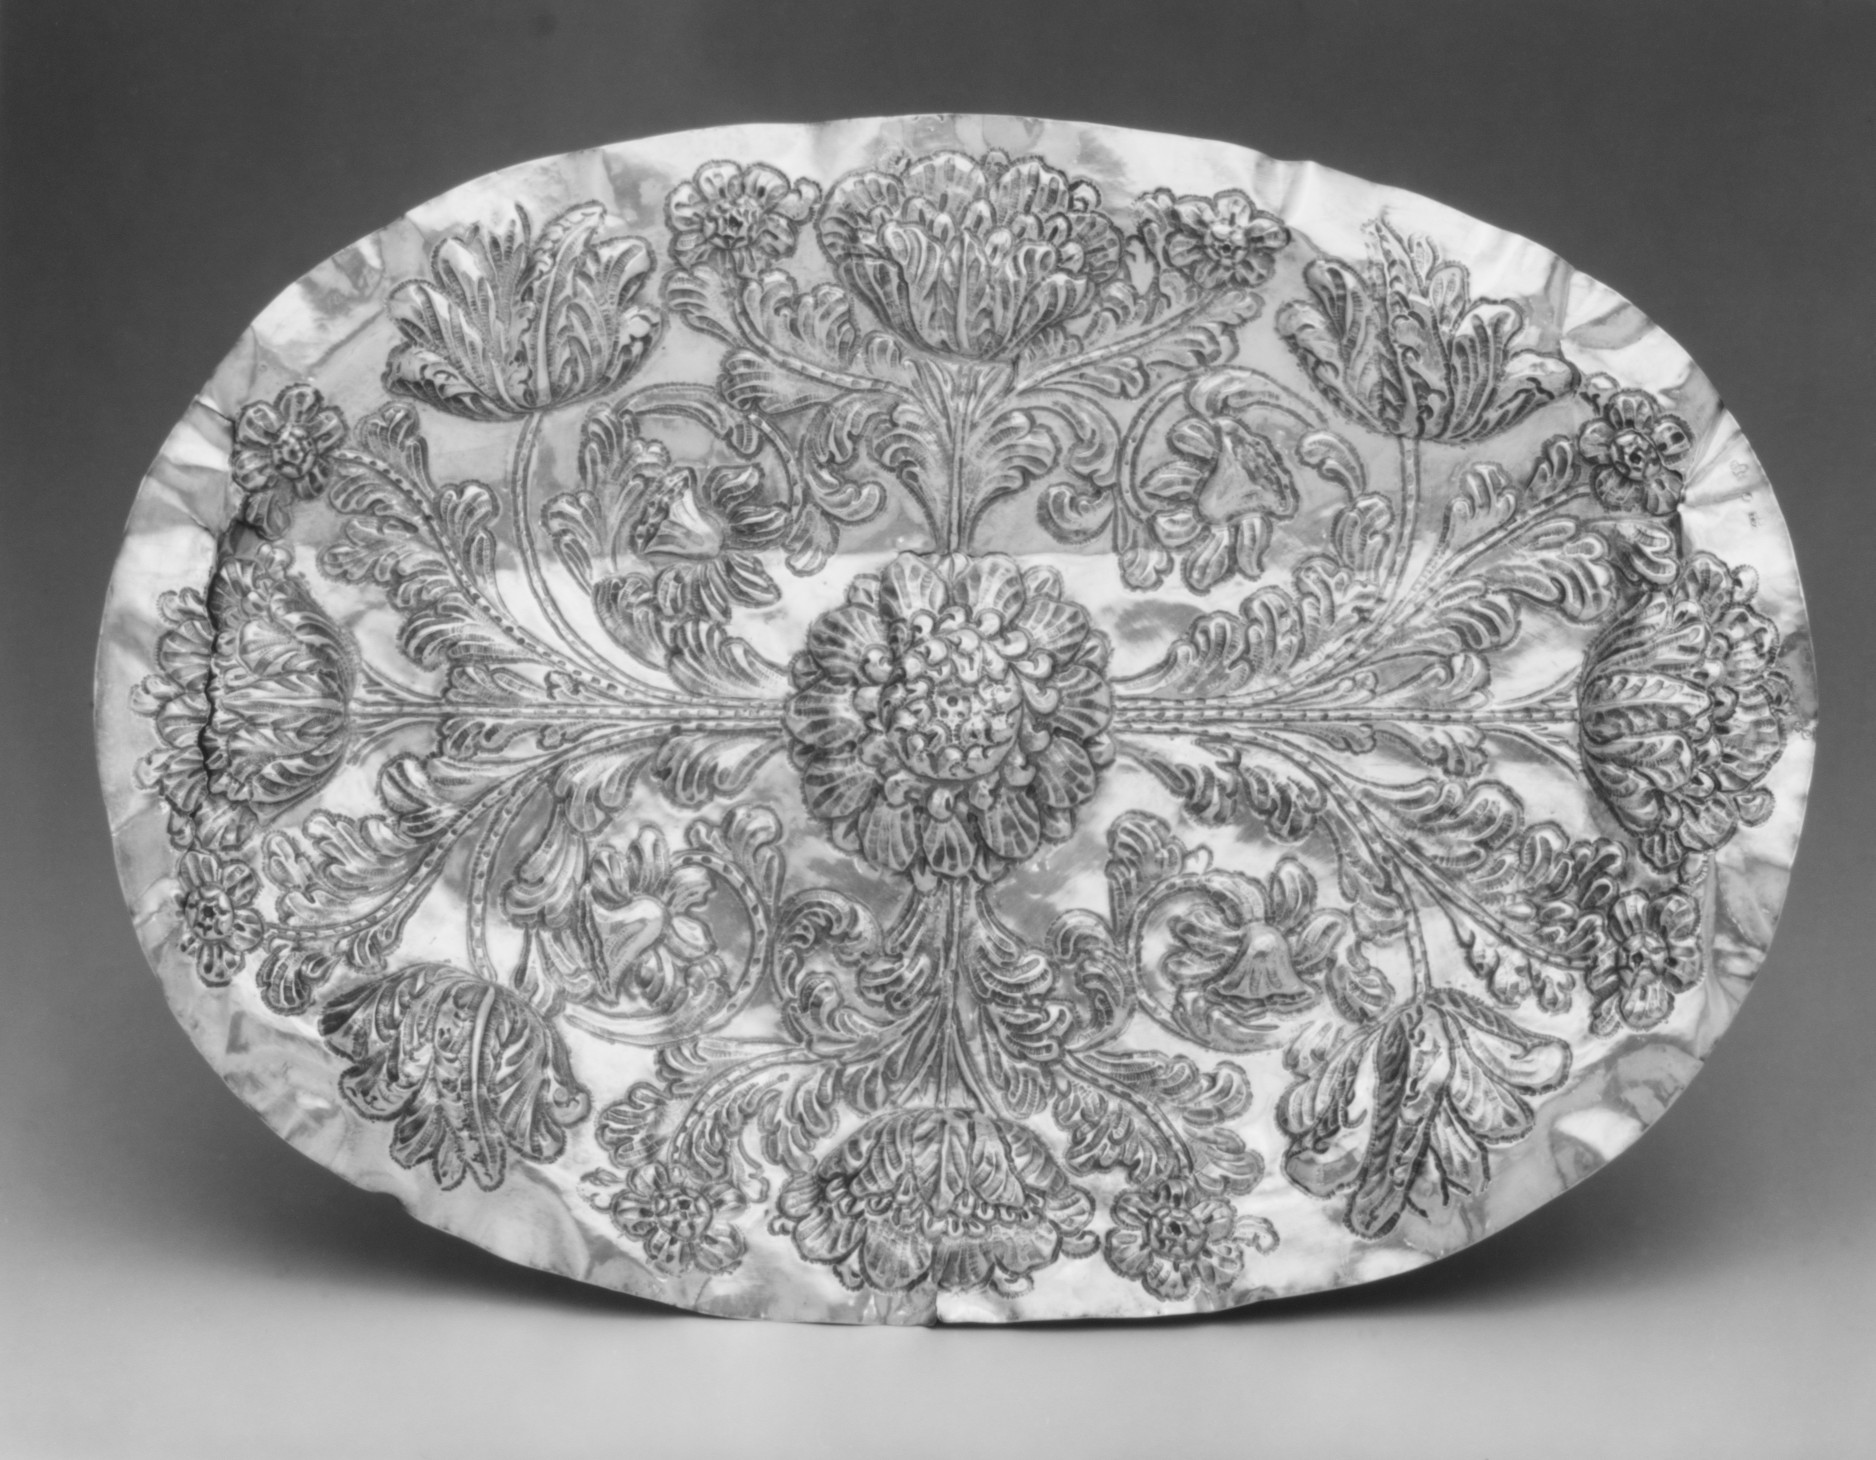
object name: platter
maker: t. v. a., barcelona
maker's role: maker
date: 1659-1700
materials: silver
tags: flowers